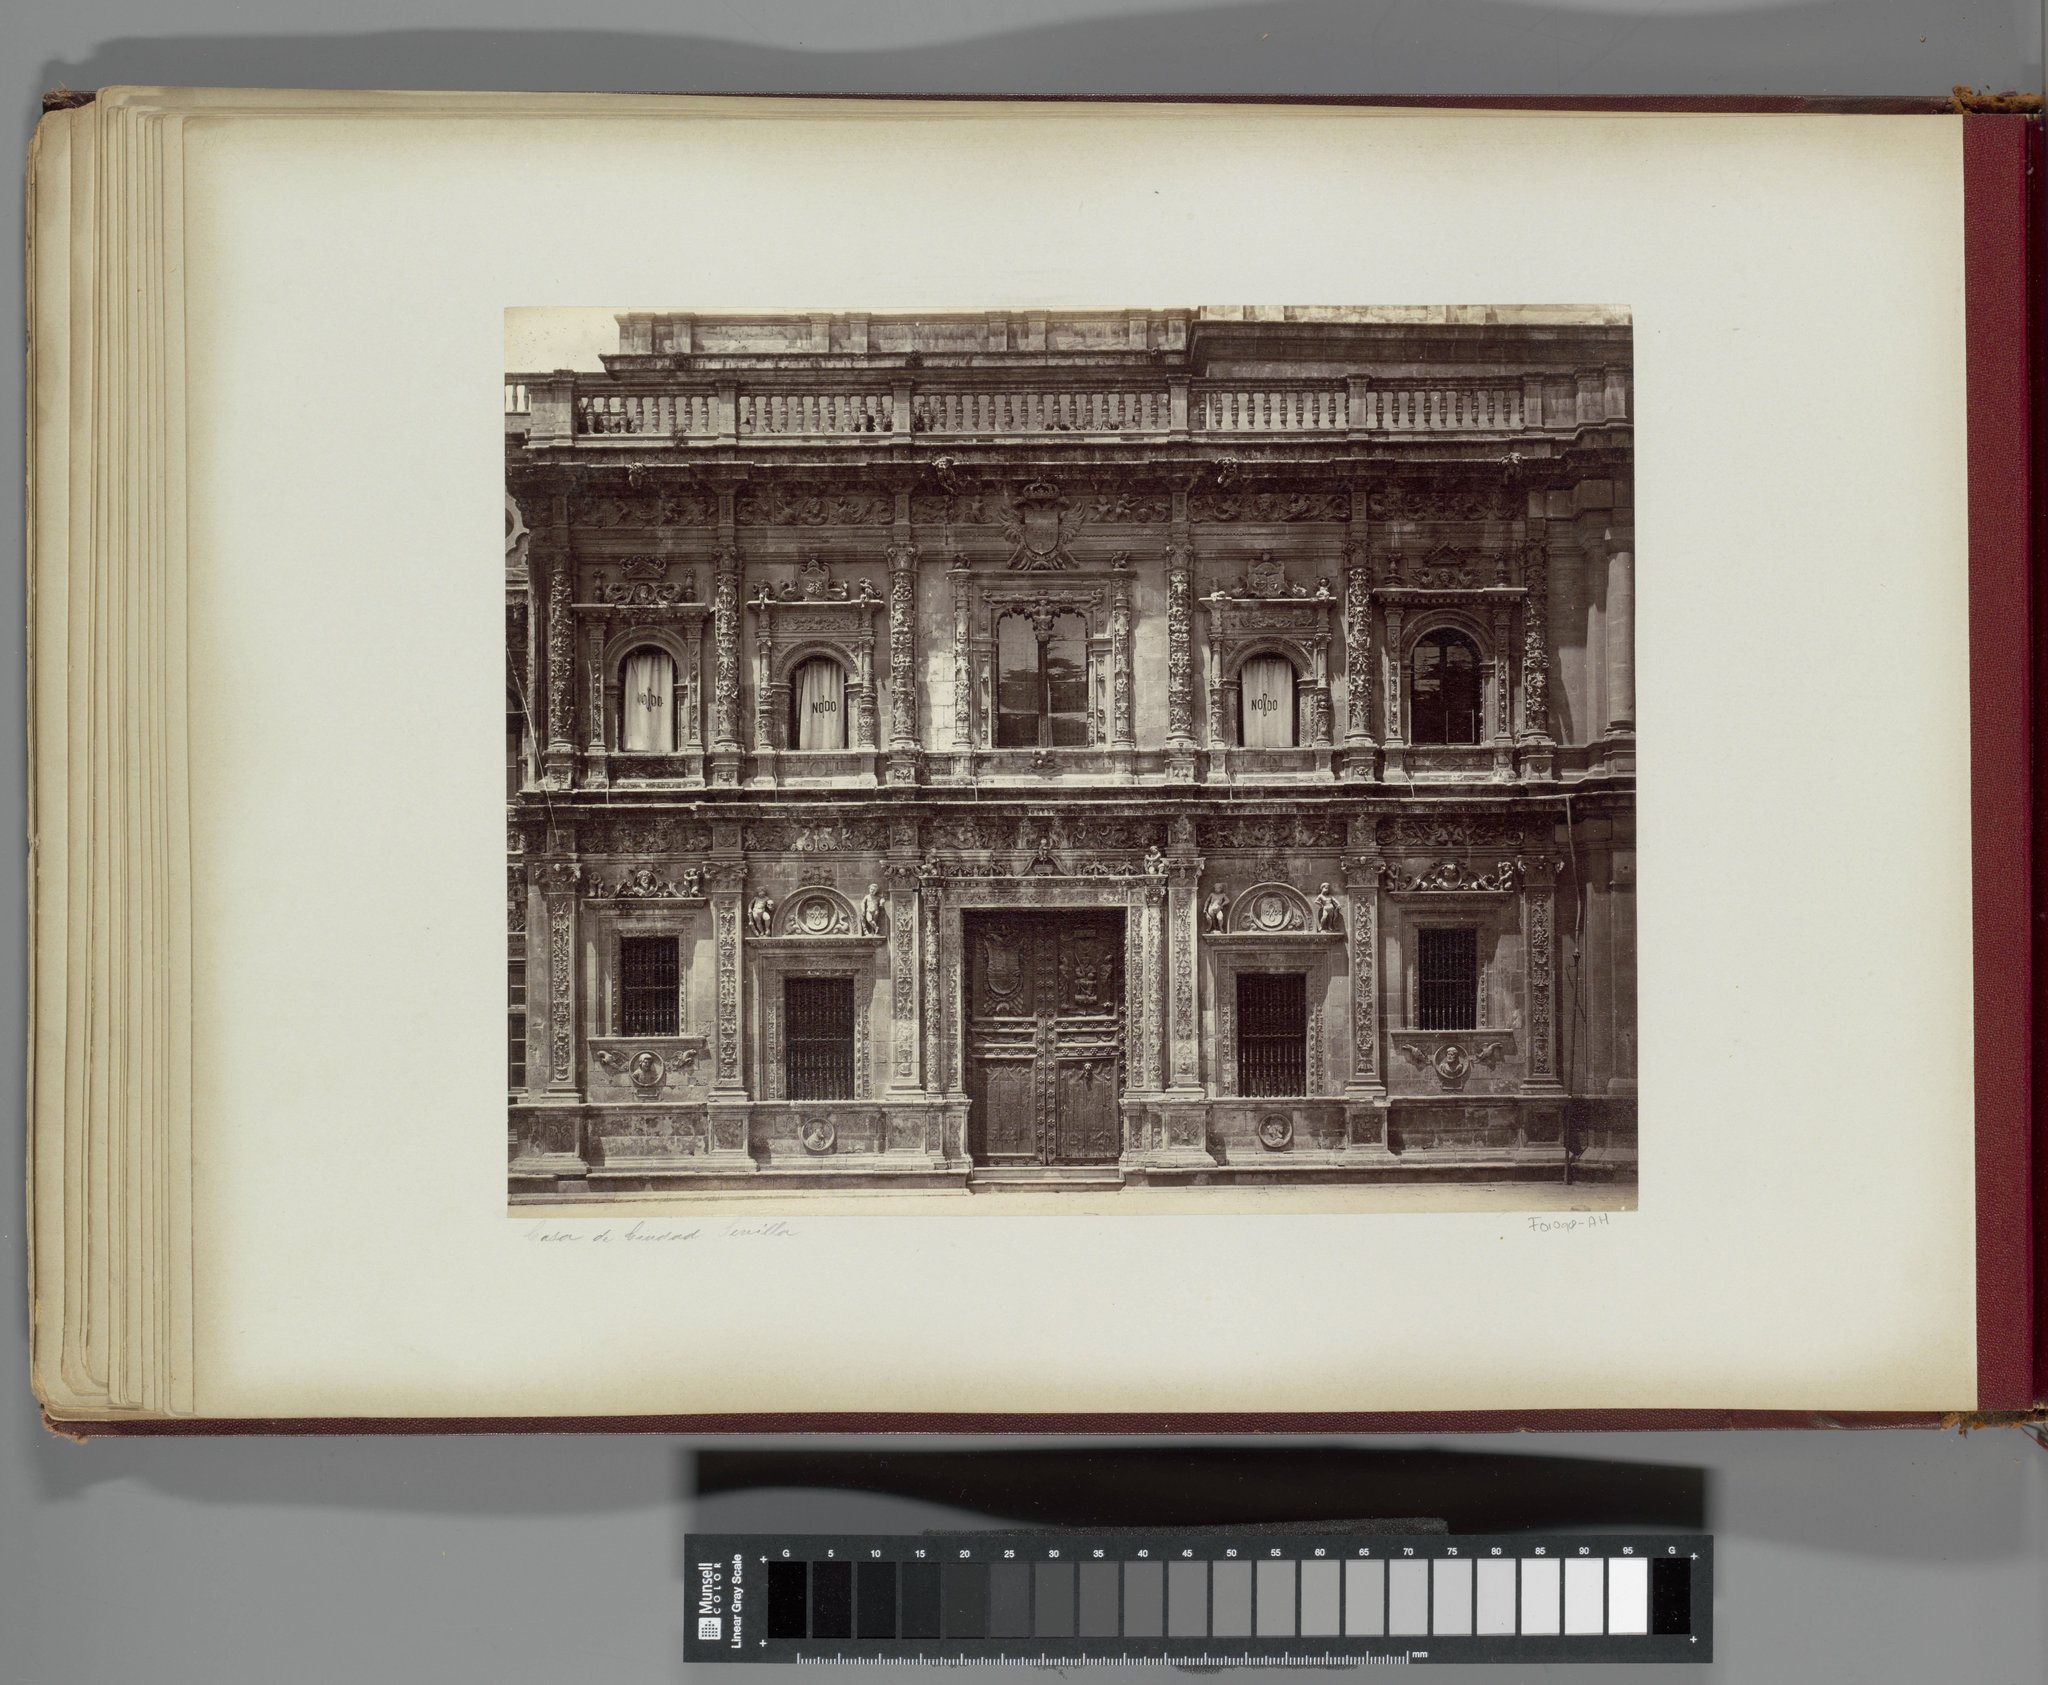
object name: photograph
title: Gevel van het stadhuis van Sevilla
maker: Anonymous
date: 1860-1880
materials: cardboard, paper, photographic support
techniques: albumen print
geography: sevilla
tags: townhall, façade (of house or building), sevilla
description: Onderdeel van Reisalbum met foto's van bezienswaardigheden in Spanje en Marokko.